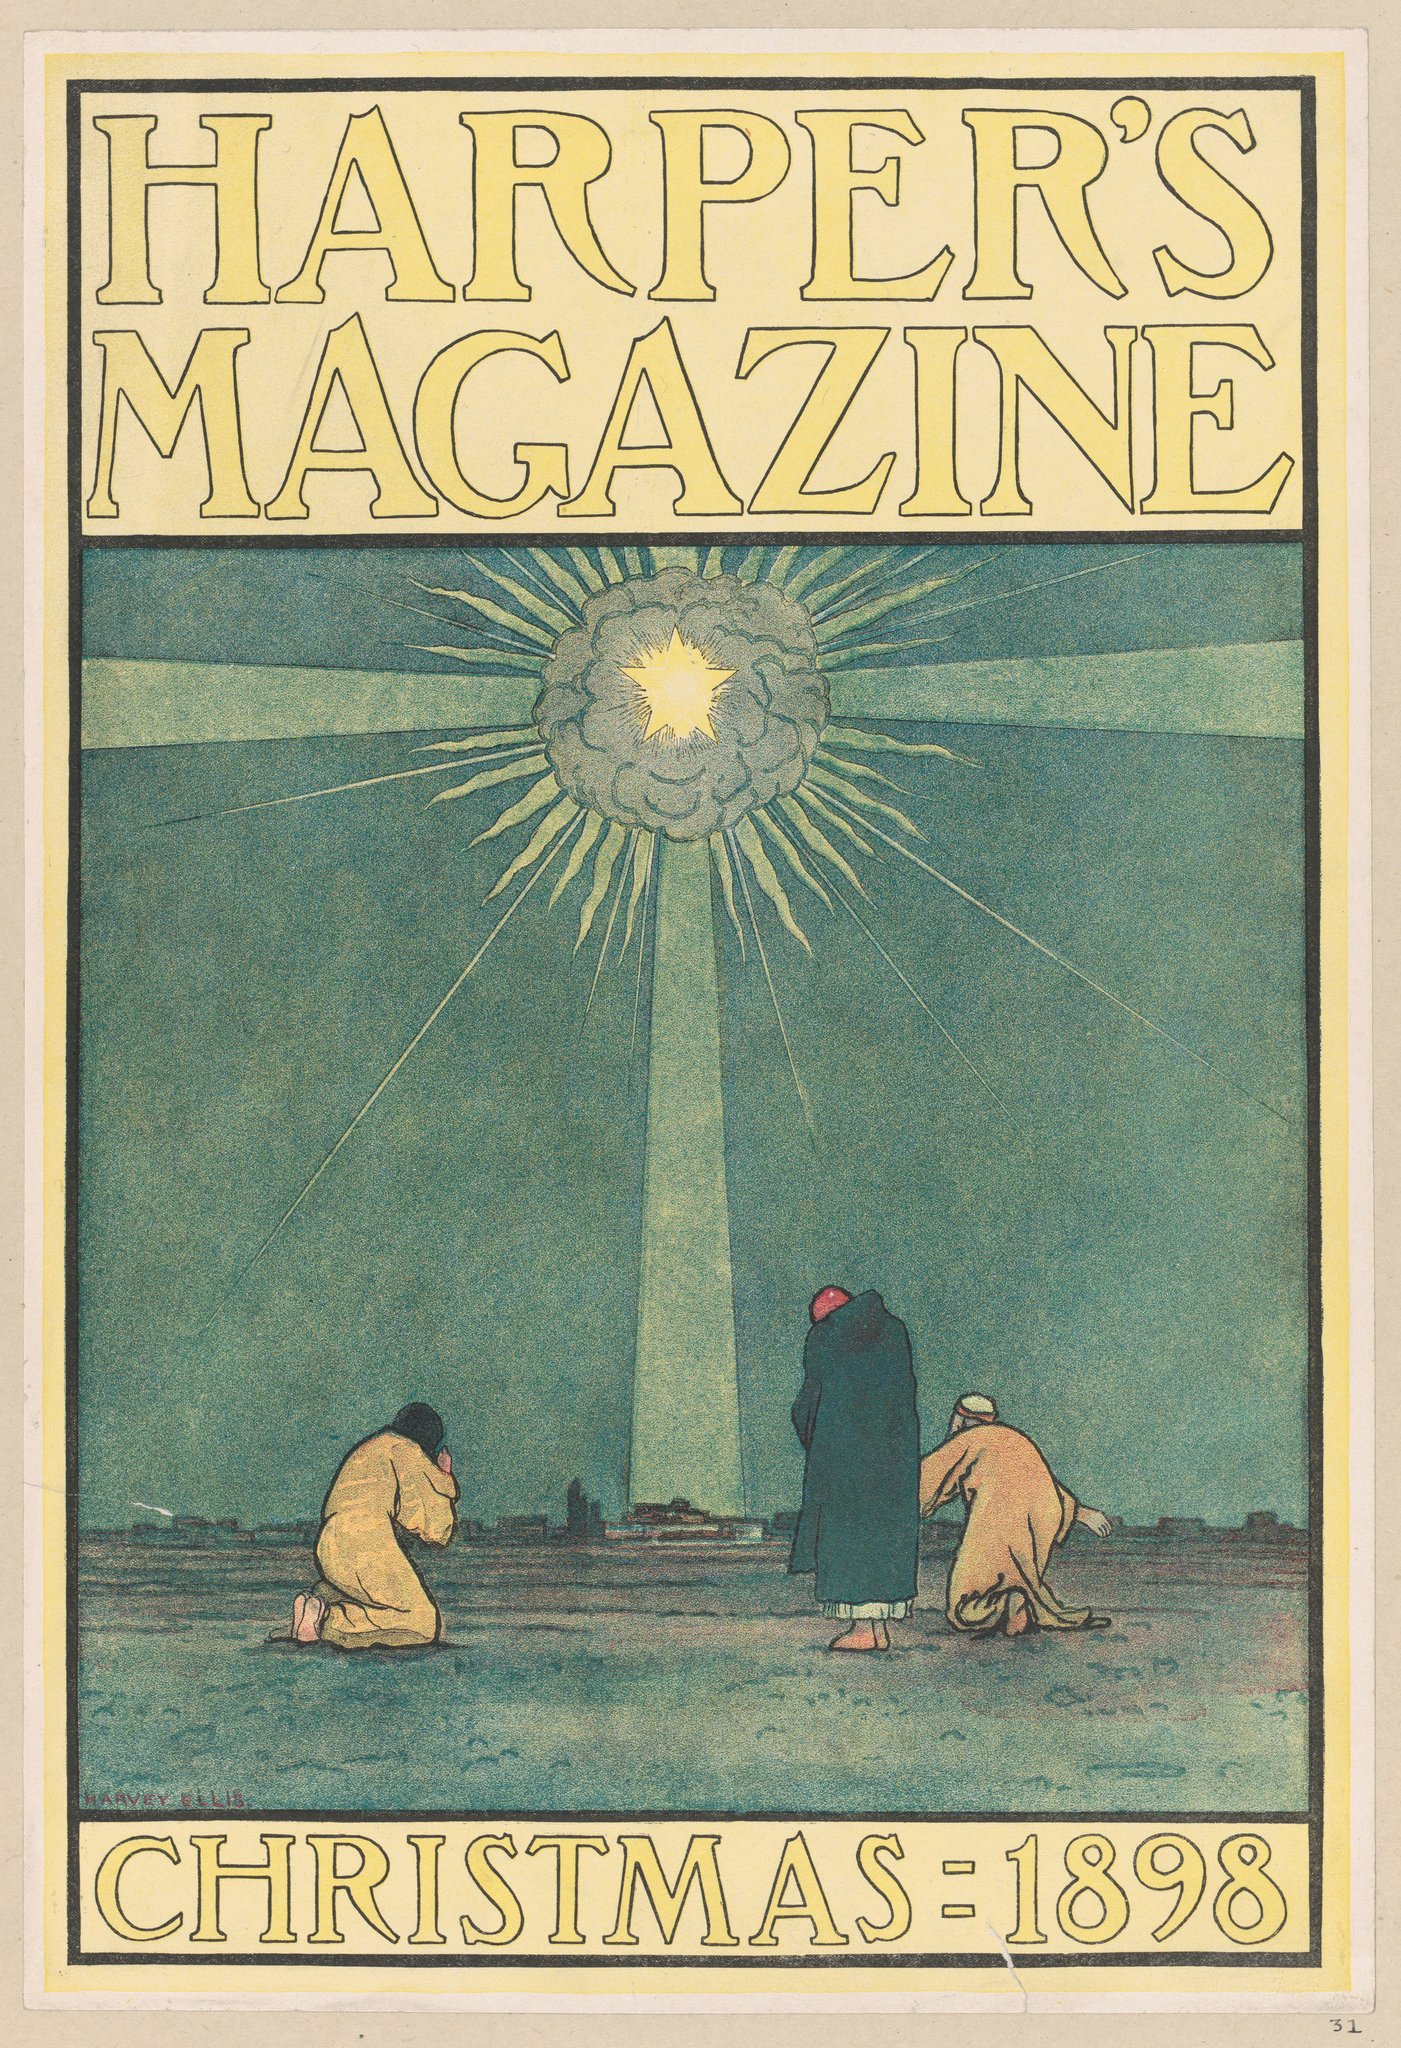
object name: print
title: Harper's Magazine, Christmas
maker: harvey ellis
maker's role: artist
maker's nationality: american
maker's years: 1852-1904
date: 1898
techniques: lithograph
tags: men,christmas